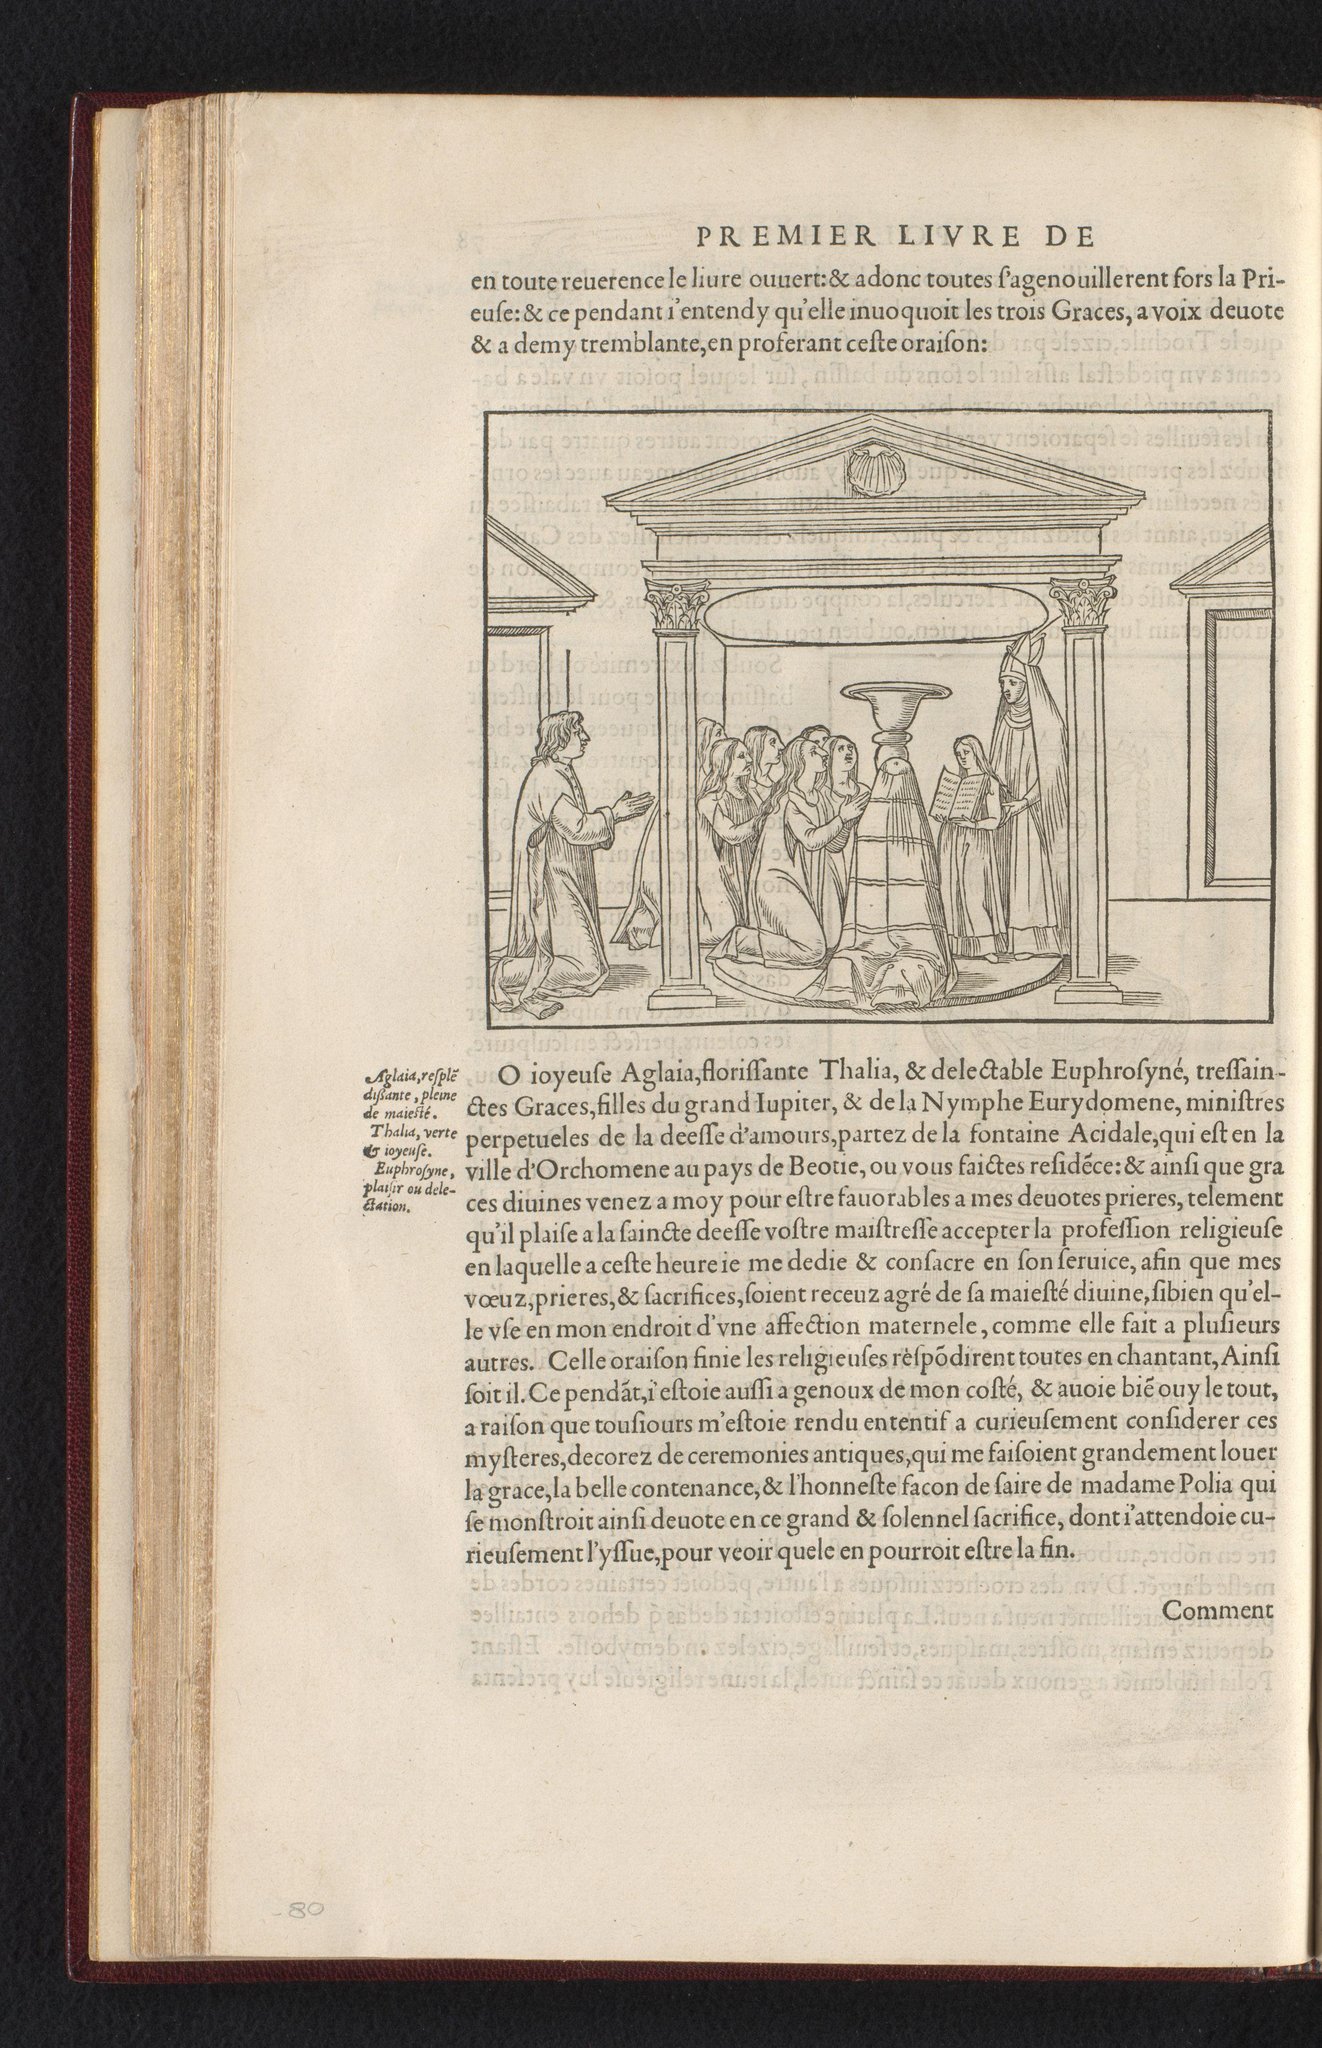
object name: print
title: Polia knielend bij een altaar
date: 1546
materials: paper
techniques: letterpress printing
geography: paris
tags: altar ~ non-christian religions, priest ~ greek religion - ee - priestess, (scenes from) specific works of literature: colonna, hypnerotomachia poliphili, kneeling on both knees - aa - female human figure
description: Prent uit: Colonna, Francesco. Hypnerotomachie ou discours du songe de Poliphile, deduisant comme amour le combat a l'occasion de Polia. Parijs: Jacques Kerver, 1546, verso fol. 78.